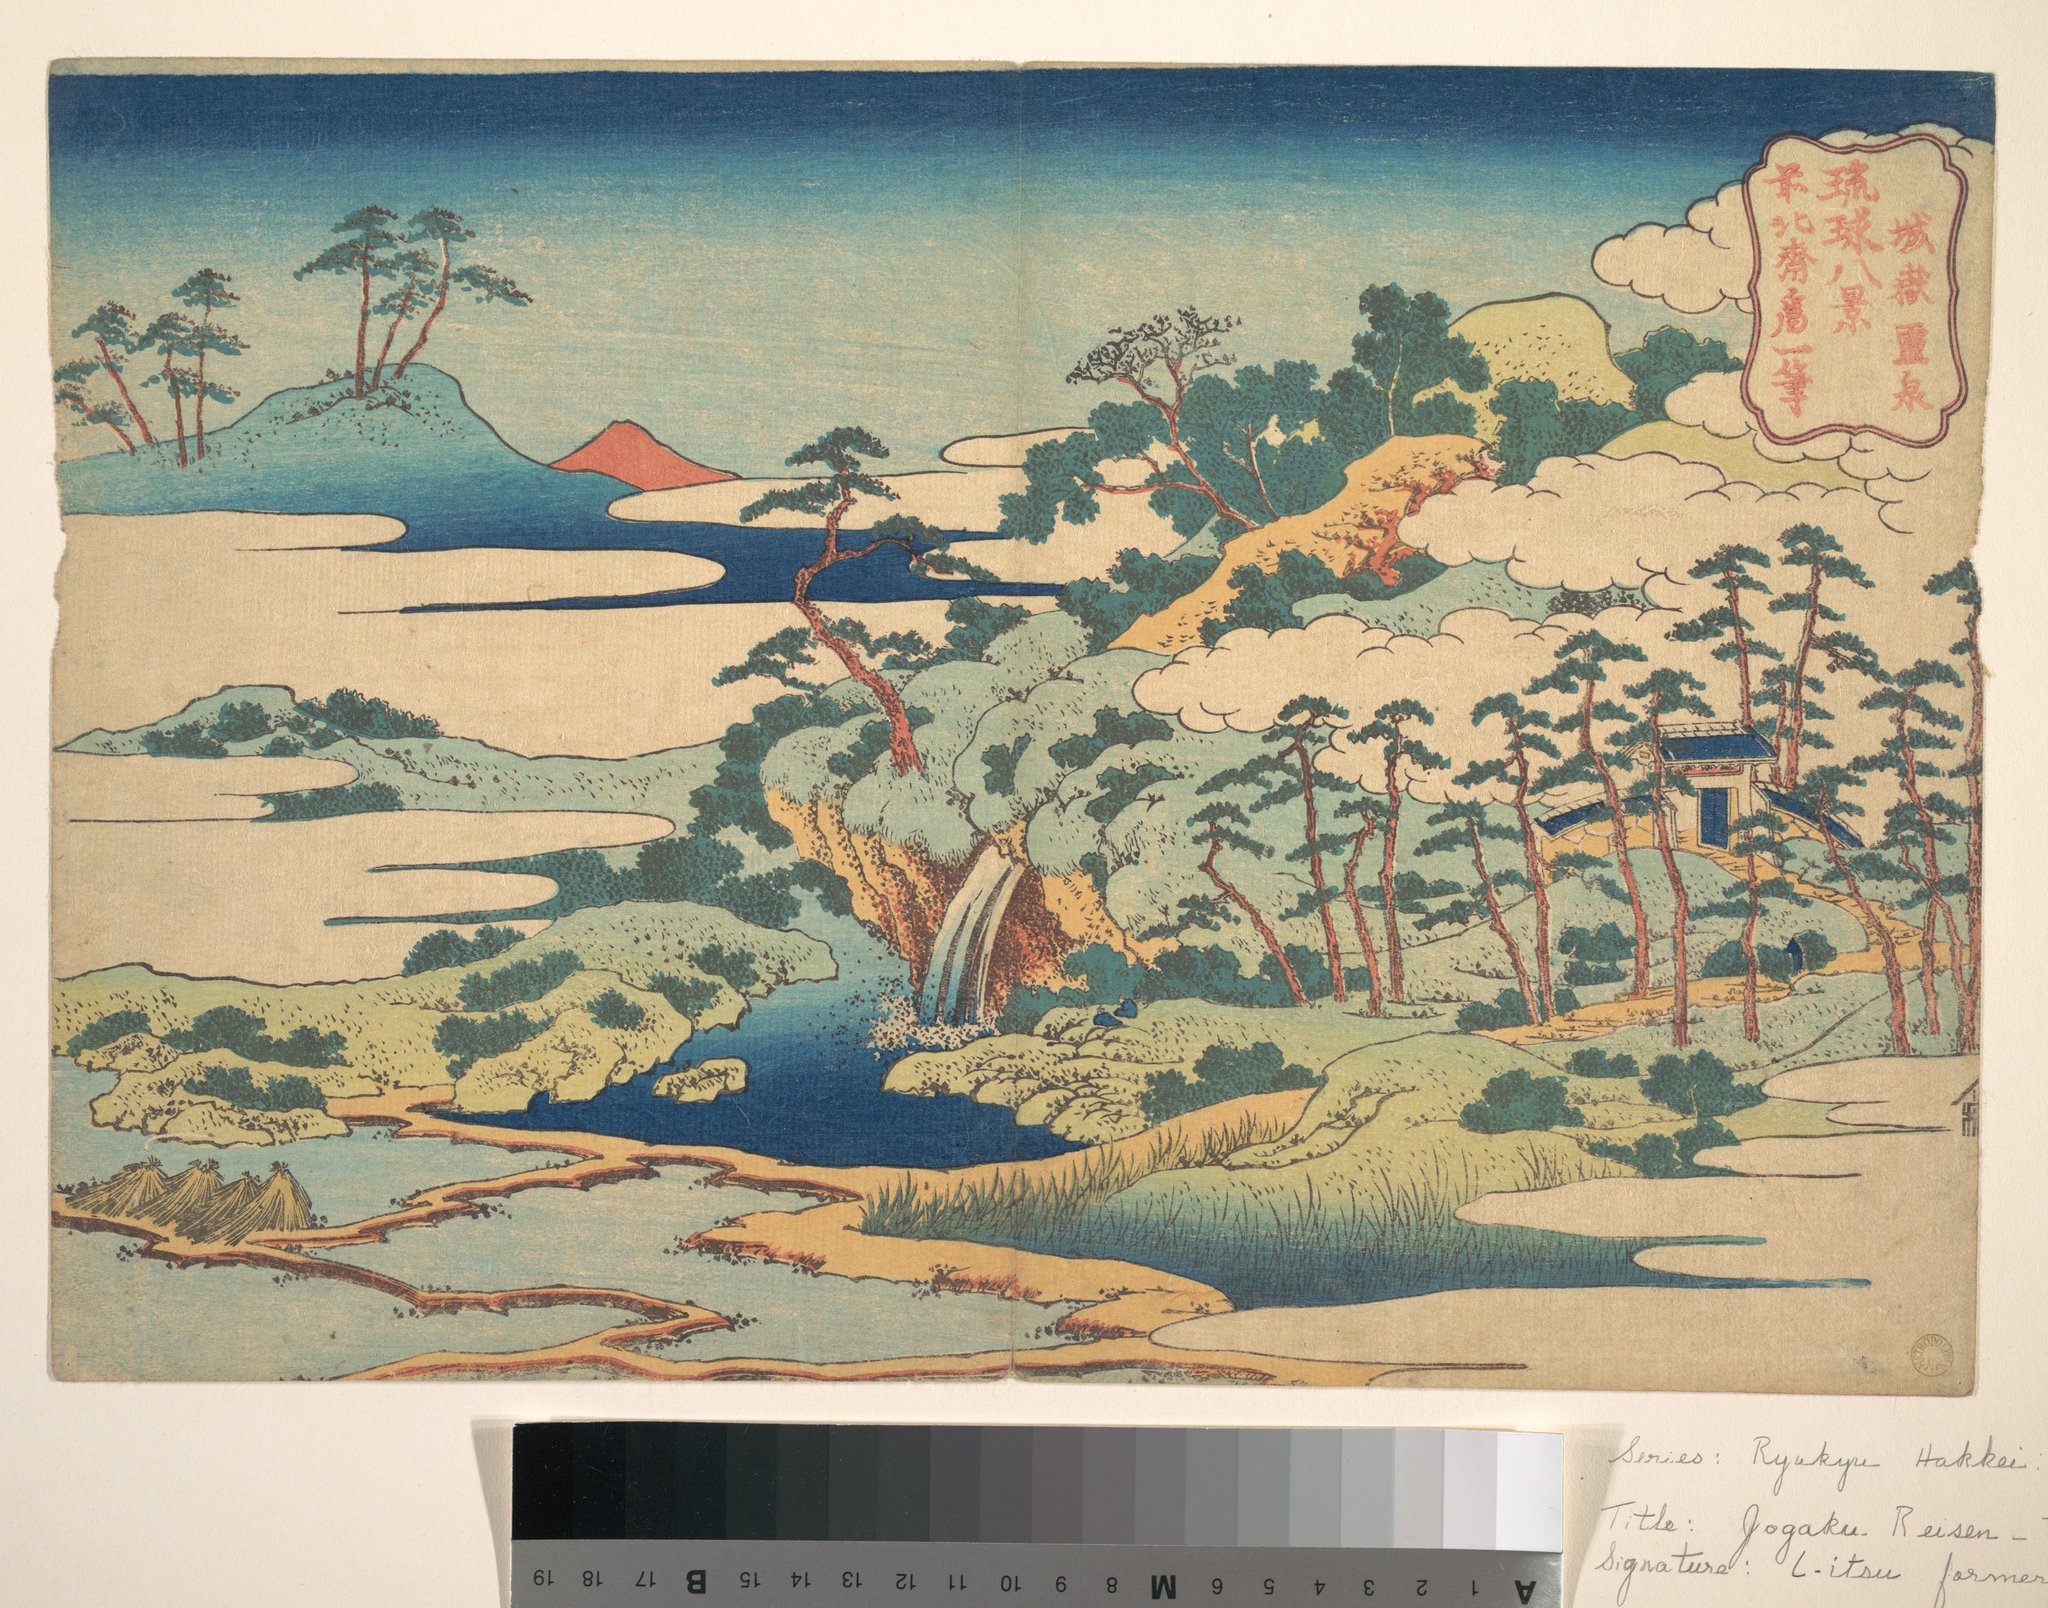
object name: woodblock print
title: The Sacred Spring at Jōgaku (Jōgaku reisen), from the series Eight Views of the Ryūkyū Islands (Ryūkyū hakkei)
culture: japanese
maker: katsushika hokusai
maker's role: artist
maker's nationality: japanese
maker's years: 1760-1849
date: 1832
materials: ink, paper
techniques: woodblock print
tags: landscapes